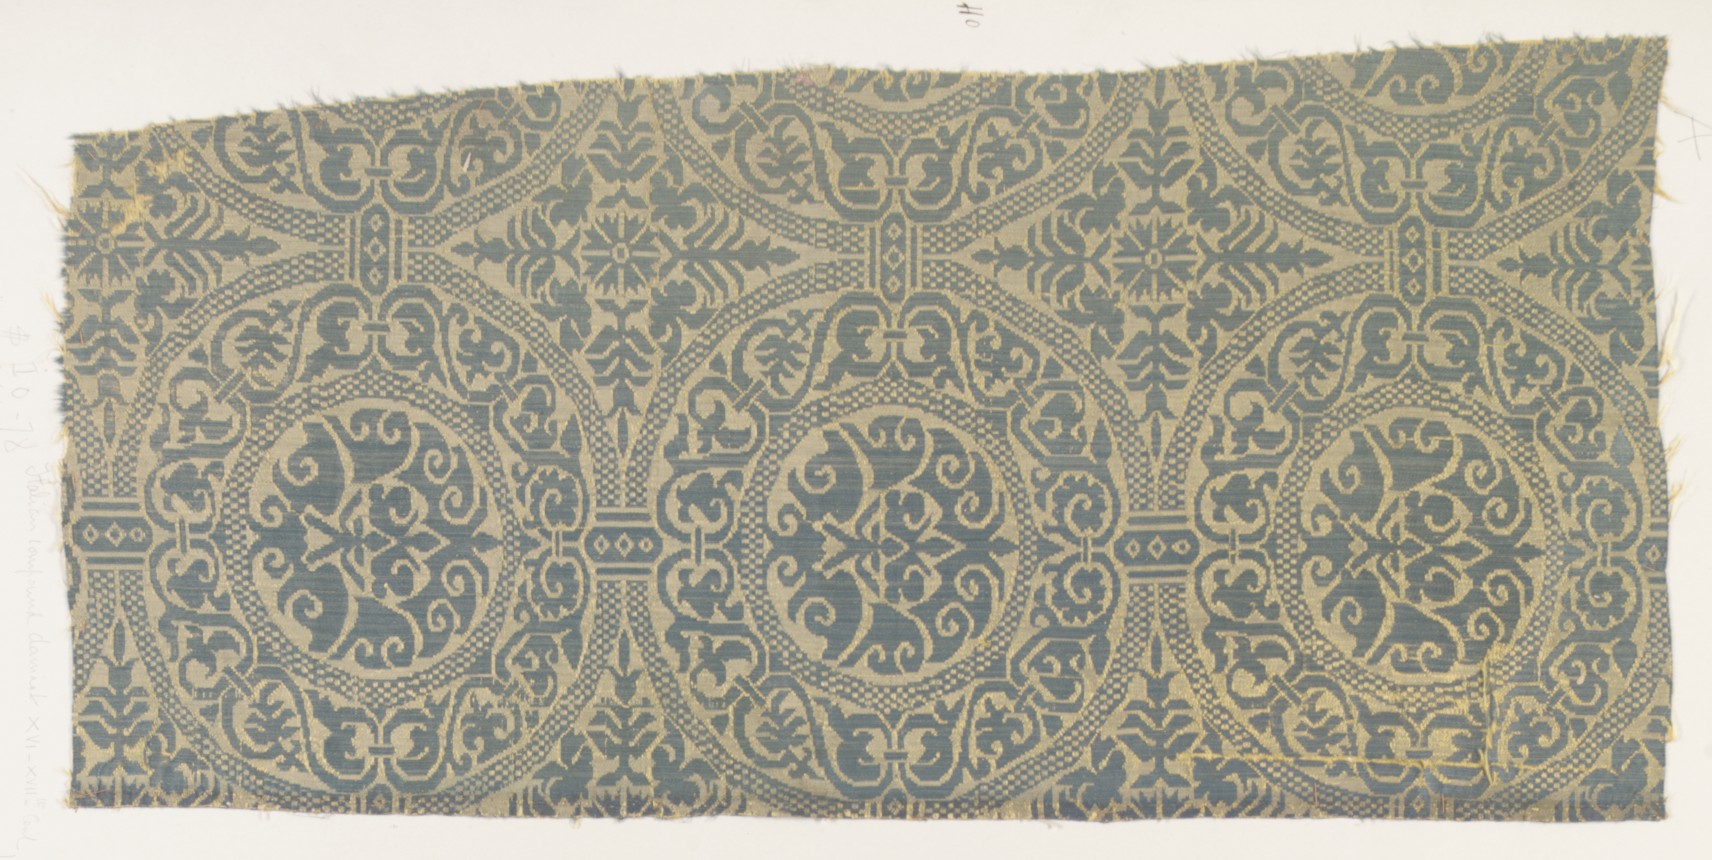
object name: fragment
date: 1501-1700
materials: silk